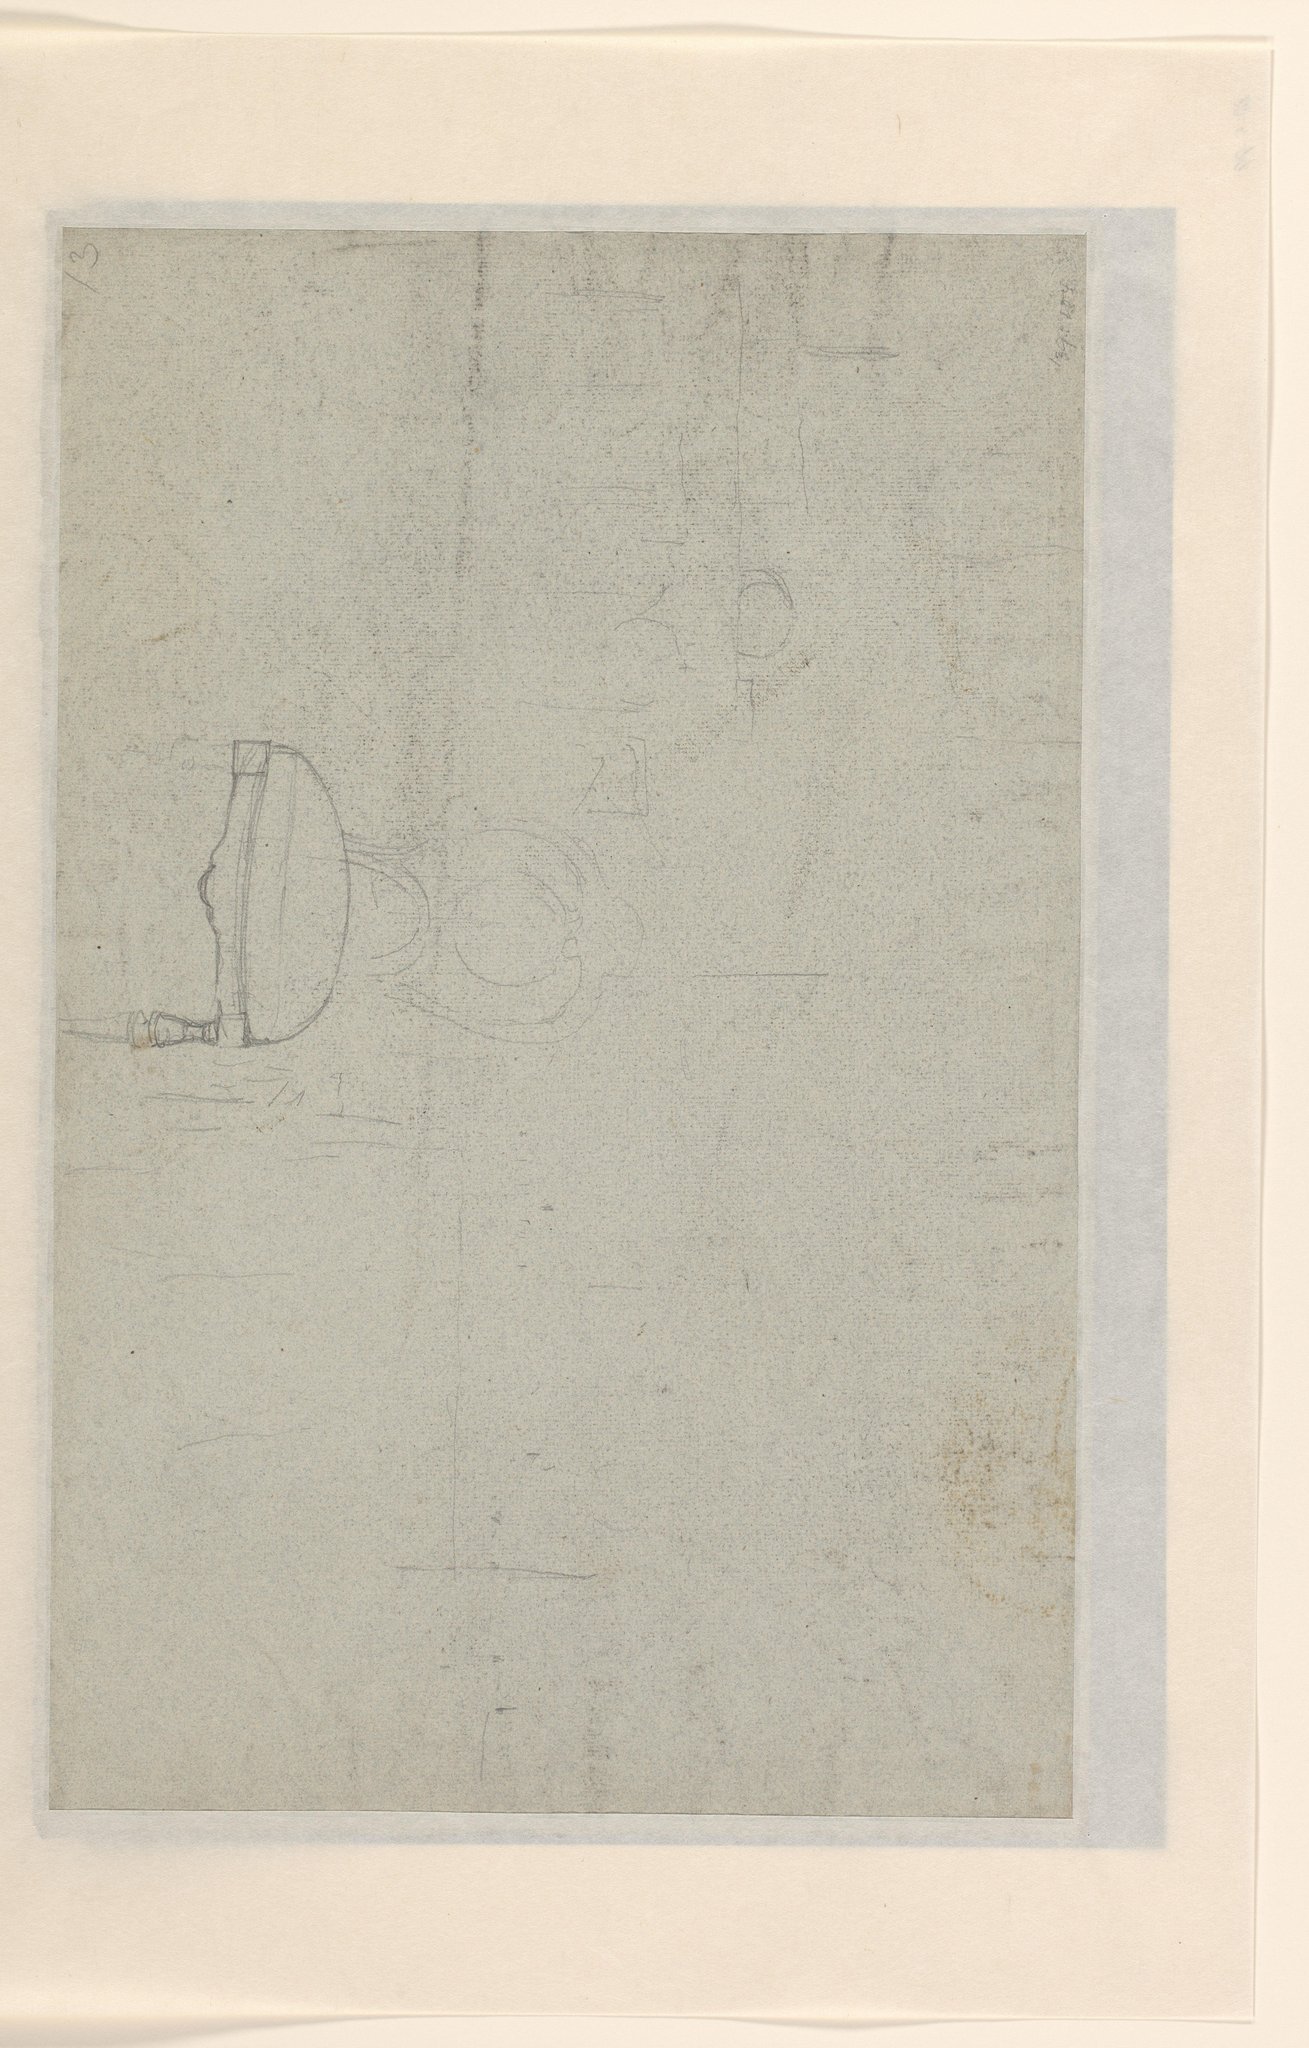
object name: drawing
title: Schets van een stoel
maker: egbert rubertus derk schaap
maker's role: draughtsman, painter, print maker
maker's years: 1862-1939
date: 1872-1939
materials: paper, pencil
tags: chair